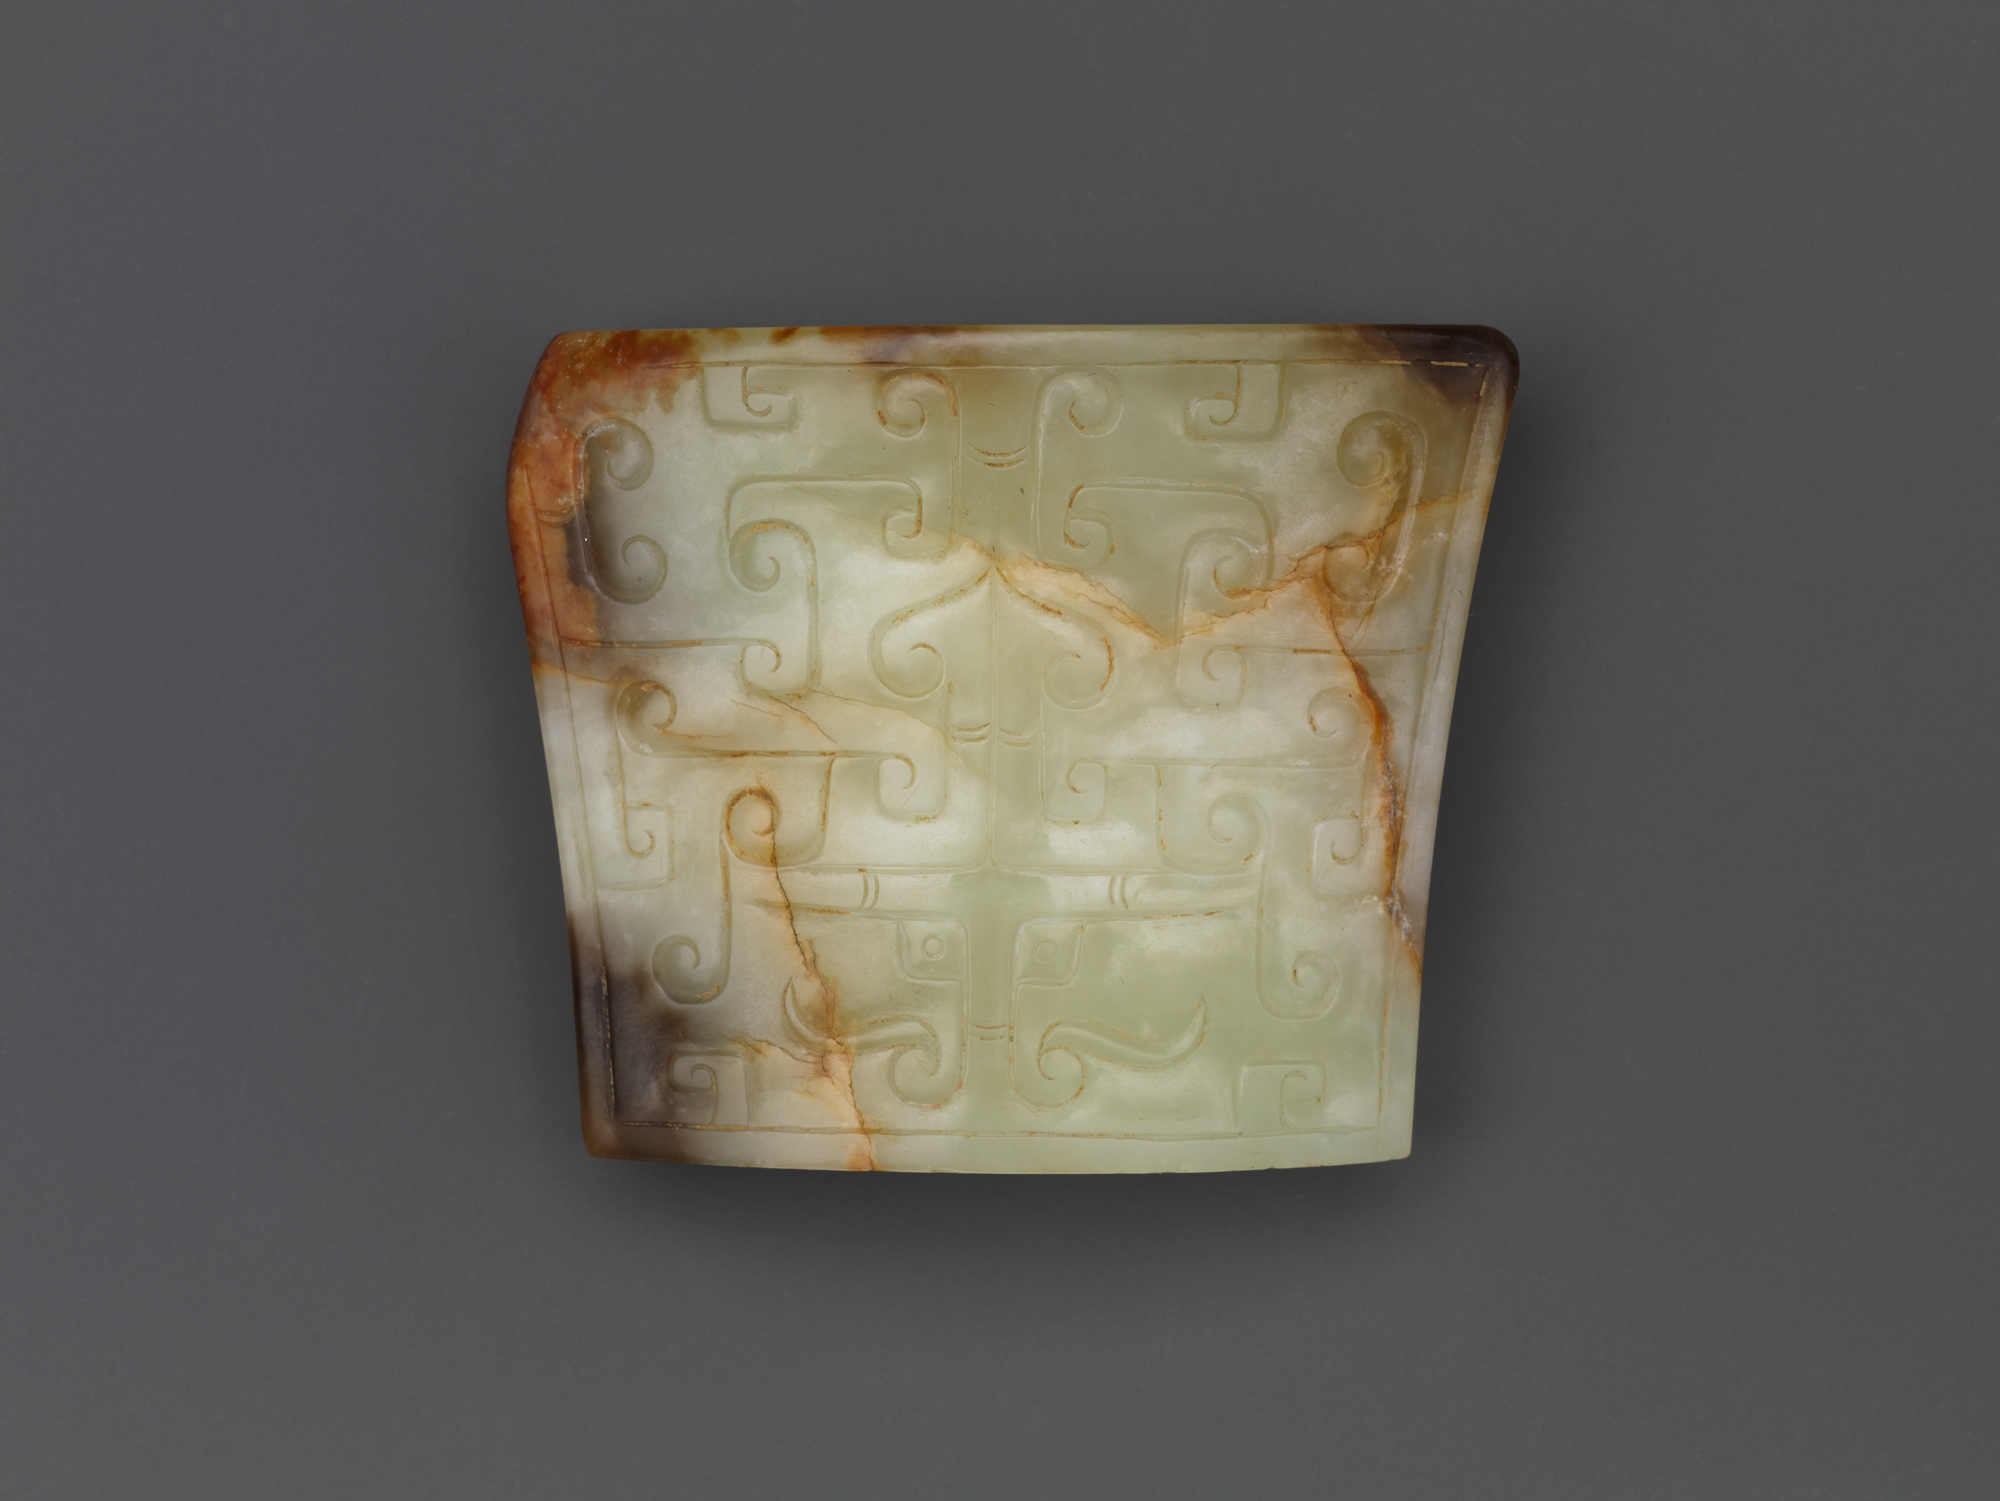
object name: scabbard chape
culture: chinese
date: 300-201 BCE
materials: jade